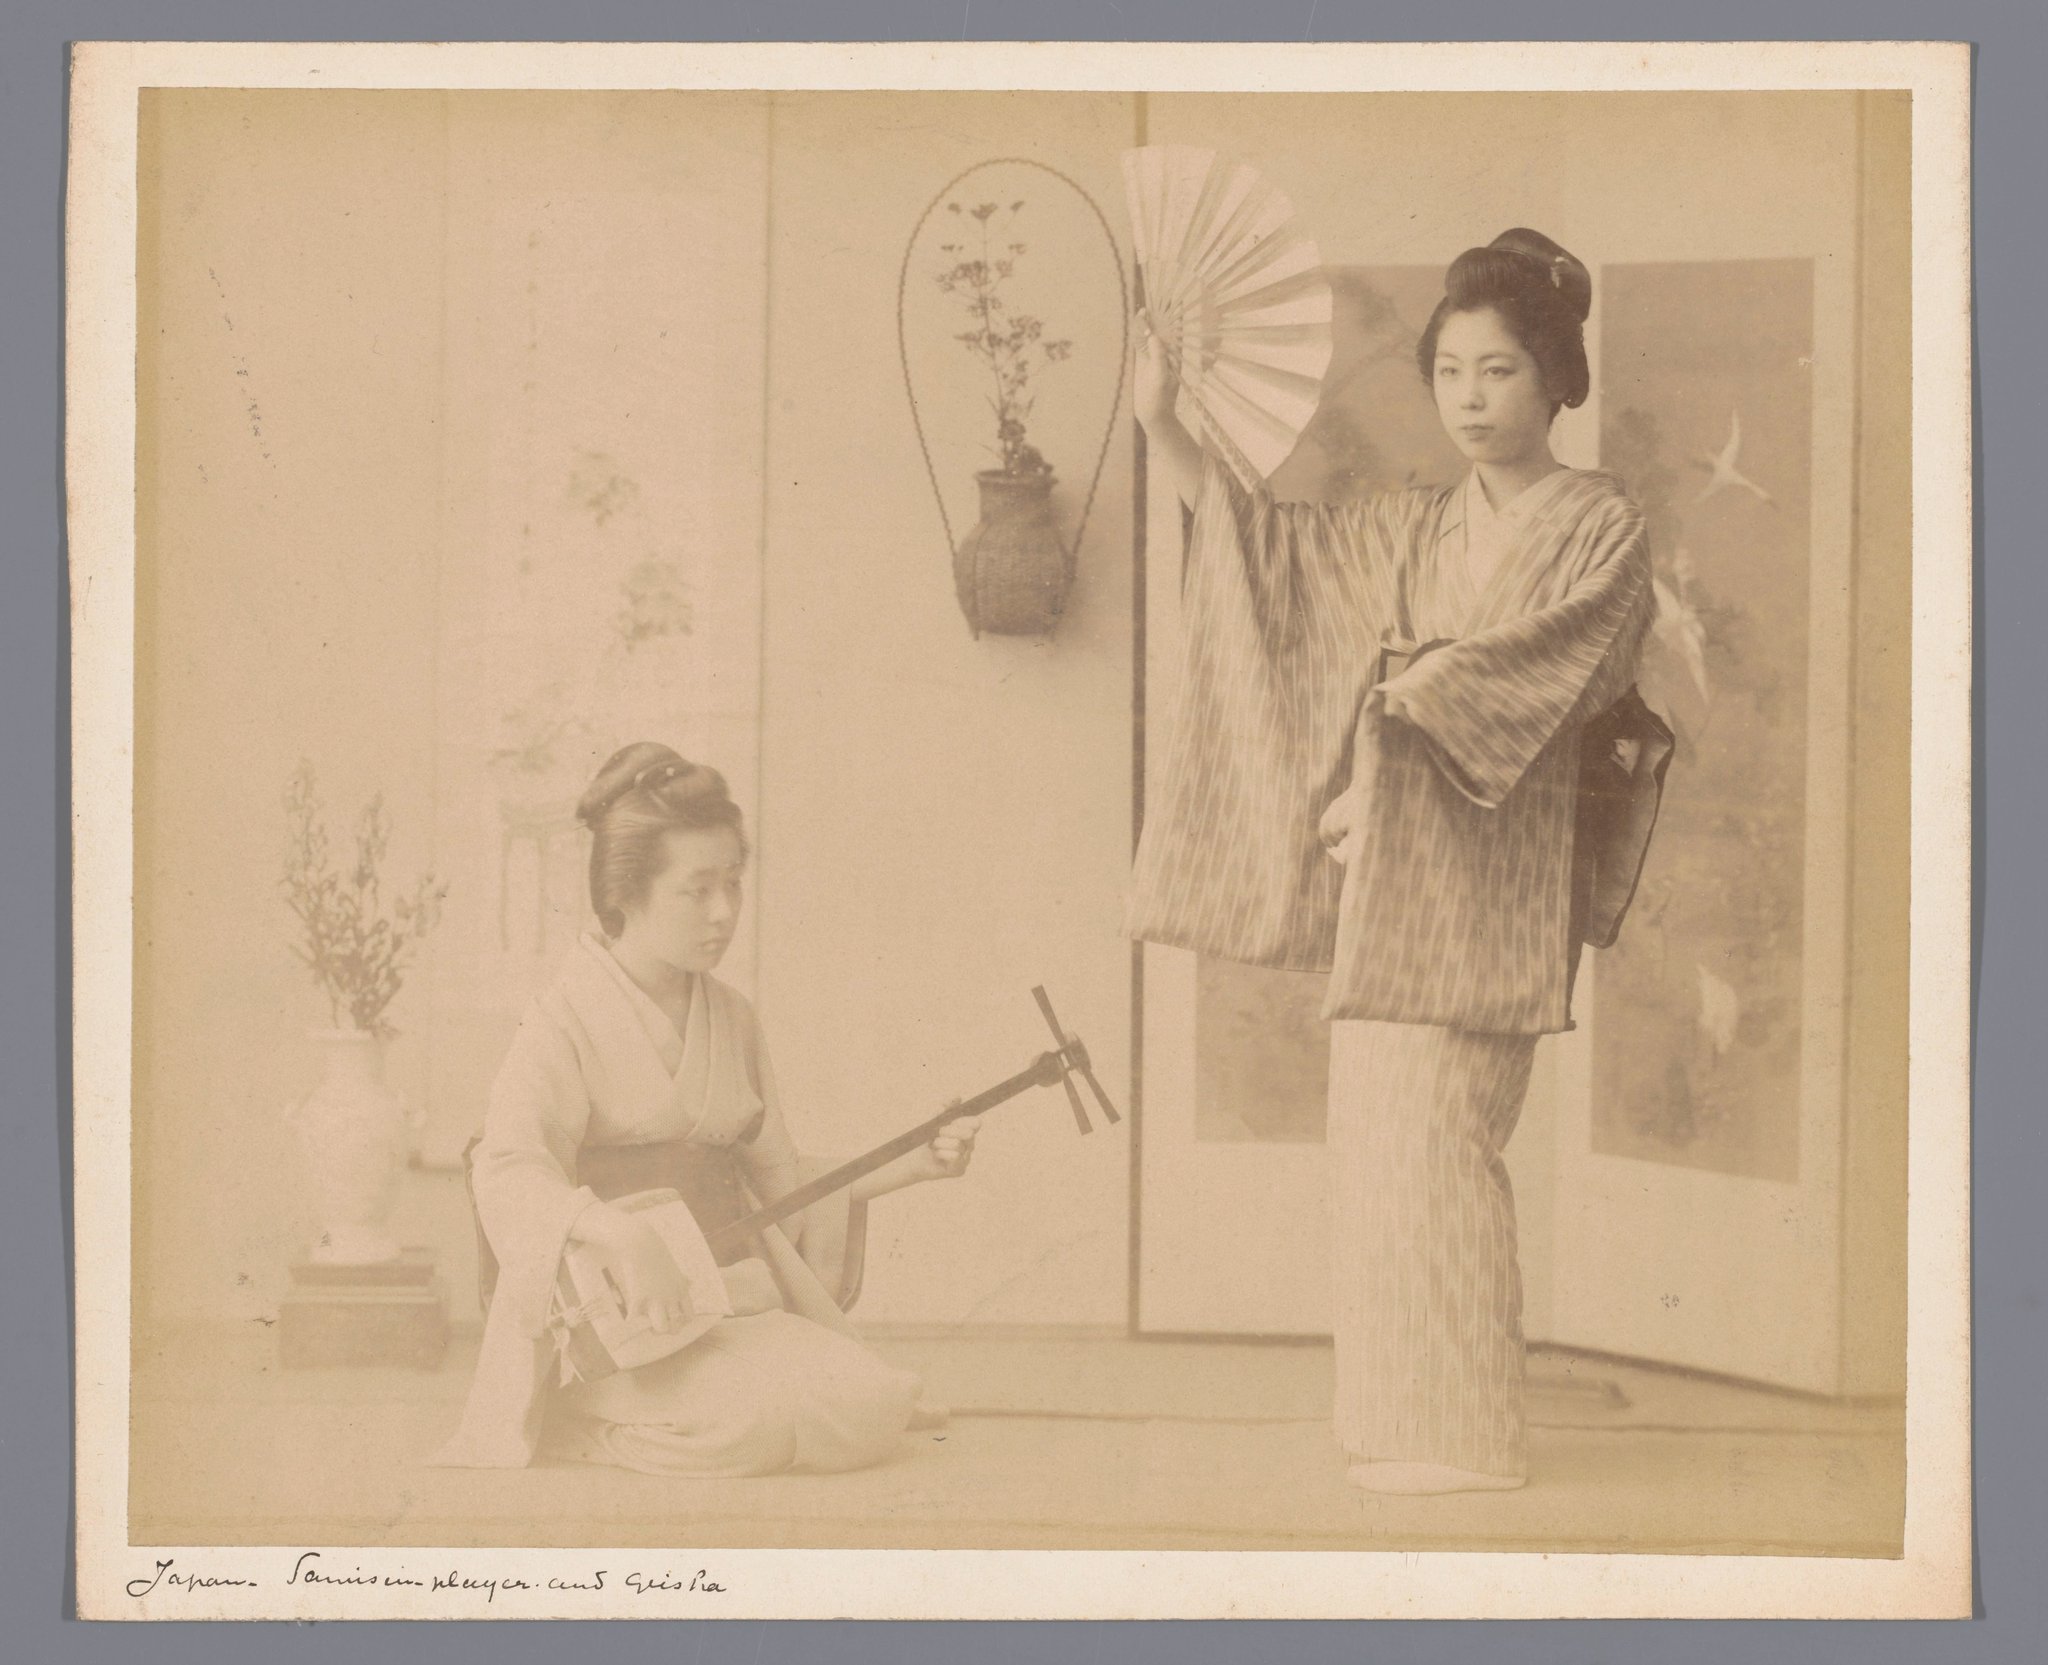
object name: photograph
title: Japan, samisin player and geisha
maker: Anonymous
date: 1860-1900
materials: cardboard, paper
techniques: albumen print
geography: japan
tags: adolescent, young woman, maiden, string instruments (plucked), japan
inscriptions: number: ‘37’